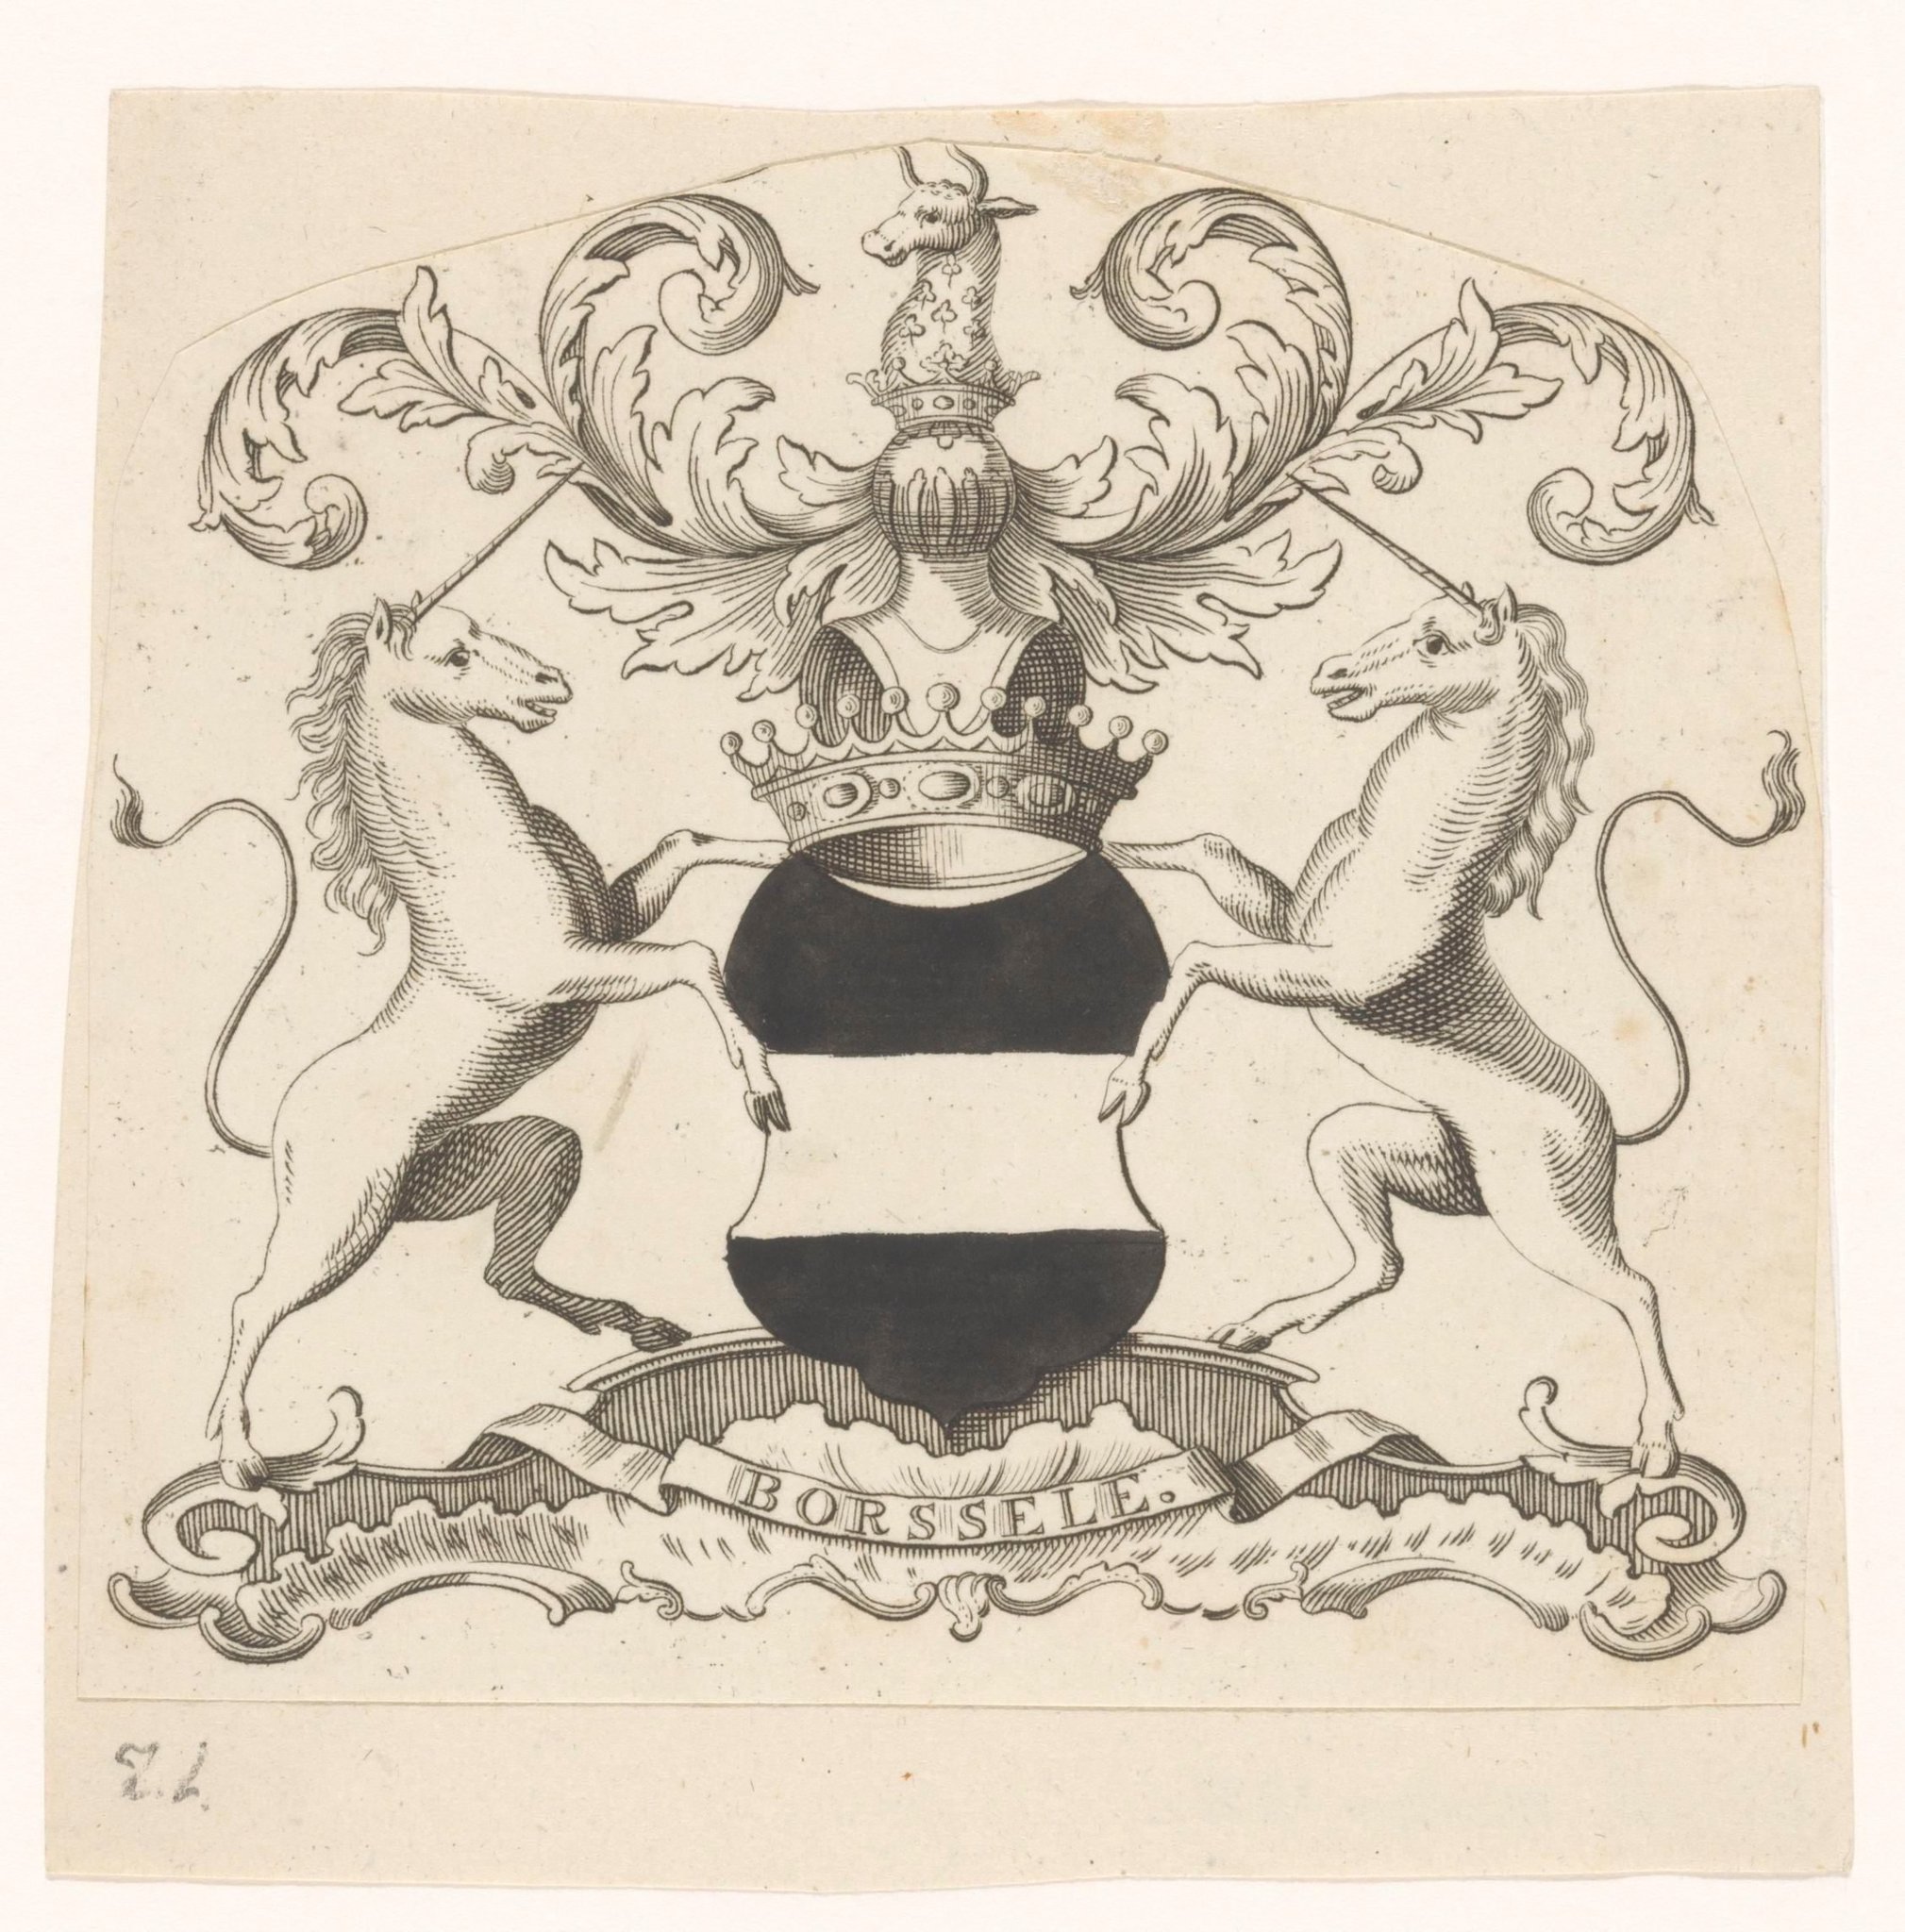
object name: print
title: Wapenschild van Borssele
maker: Anonymous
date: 1600-1800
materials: paper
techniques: etching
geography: netherlands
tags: armorial bearing, heraldry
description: Wapenschild van Borssele met helmteken met ossenkop en twee eenhoorns als schildhouders.